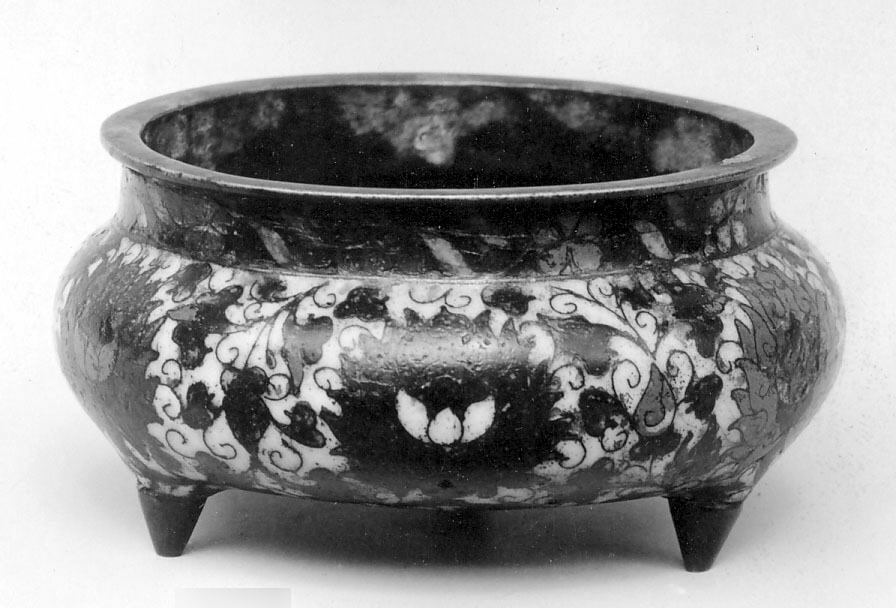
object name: incense burner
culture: chinese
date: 1368-1644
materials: copper, enamel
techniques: enamel